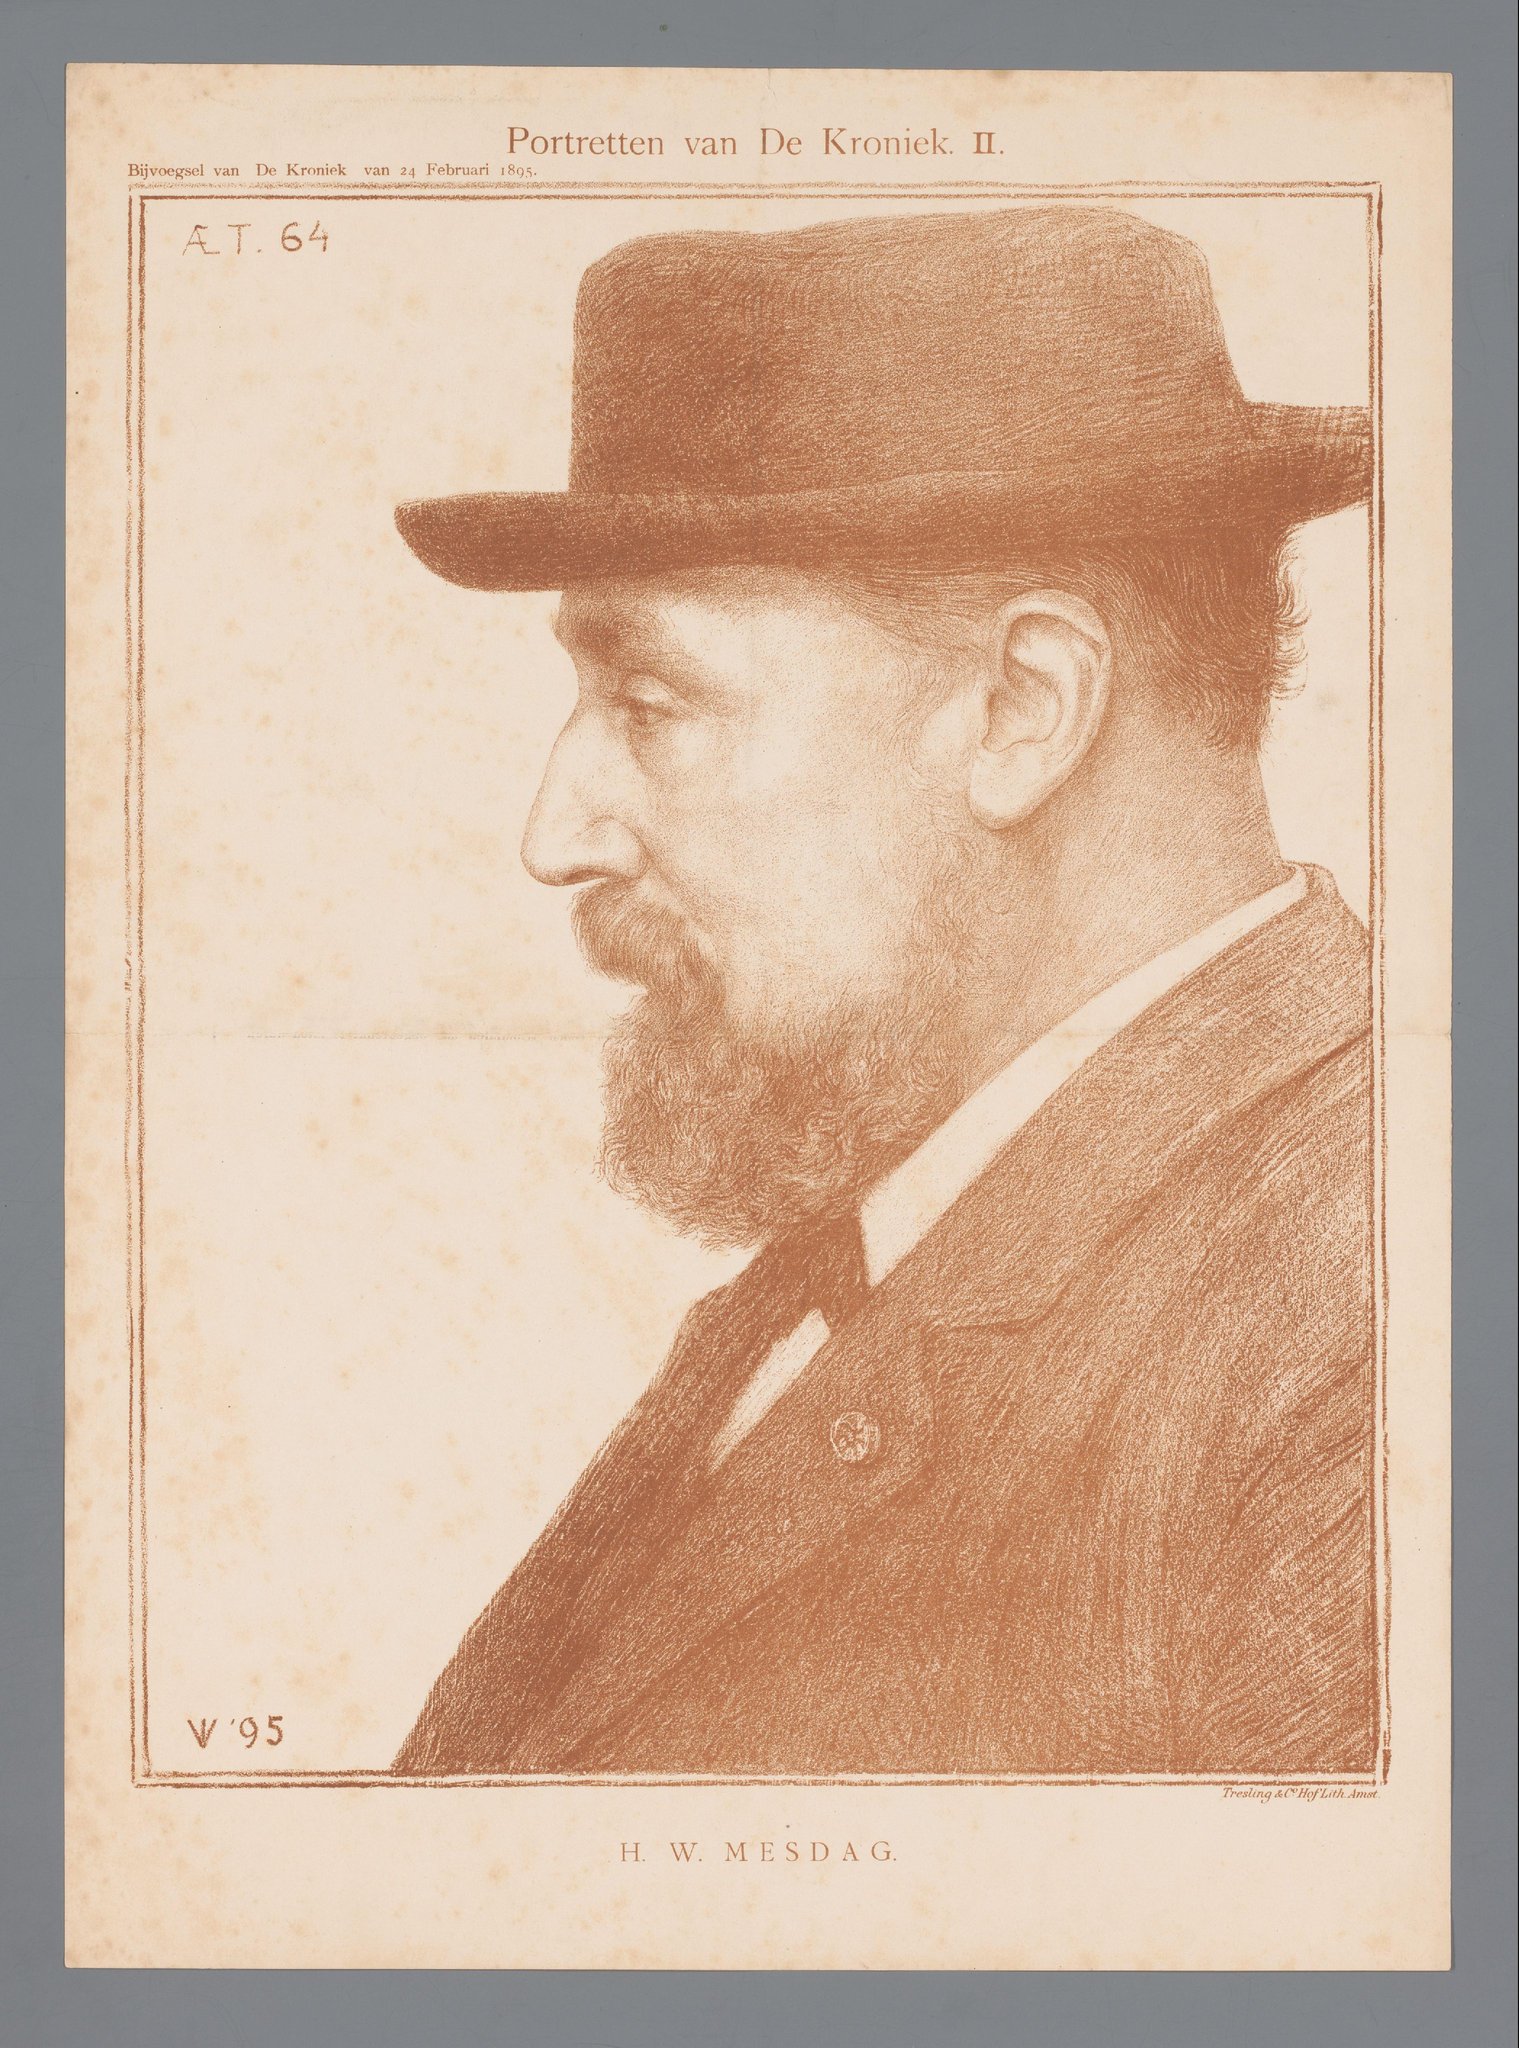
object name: print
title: H.W. Mesdag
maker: jan veth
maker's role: designer, draughtsman, painter, print maker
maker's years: 1864-1925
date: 1895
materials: paper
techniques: lithograph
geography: amsterdam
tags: the hague, hendrik willem mesdag, historical persons, portrait, self-portrait of painter, portrait, self-portrait of artist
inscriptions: date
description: Prent met titel en onderschrift, bijvoegsel bij 'De Kroniek'. Gesigneerd en gedateerd.